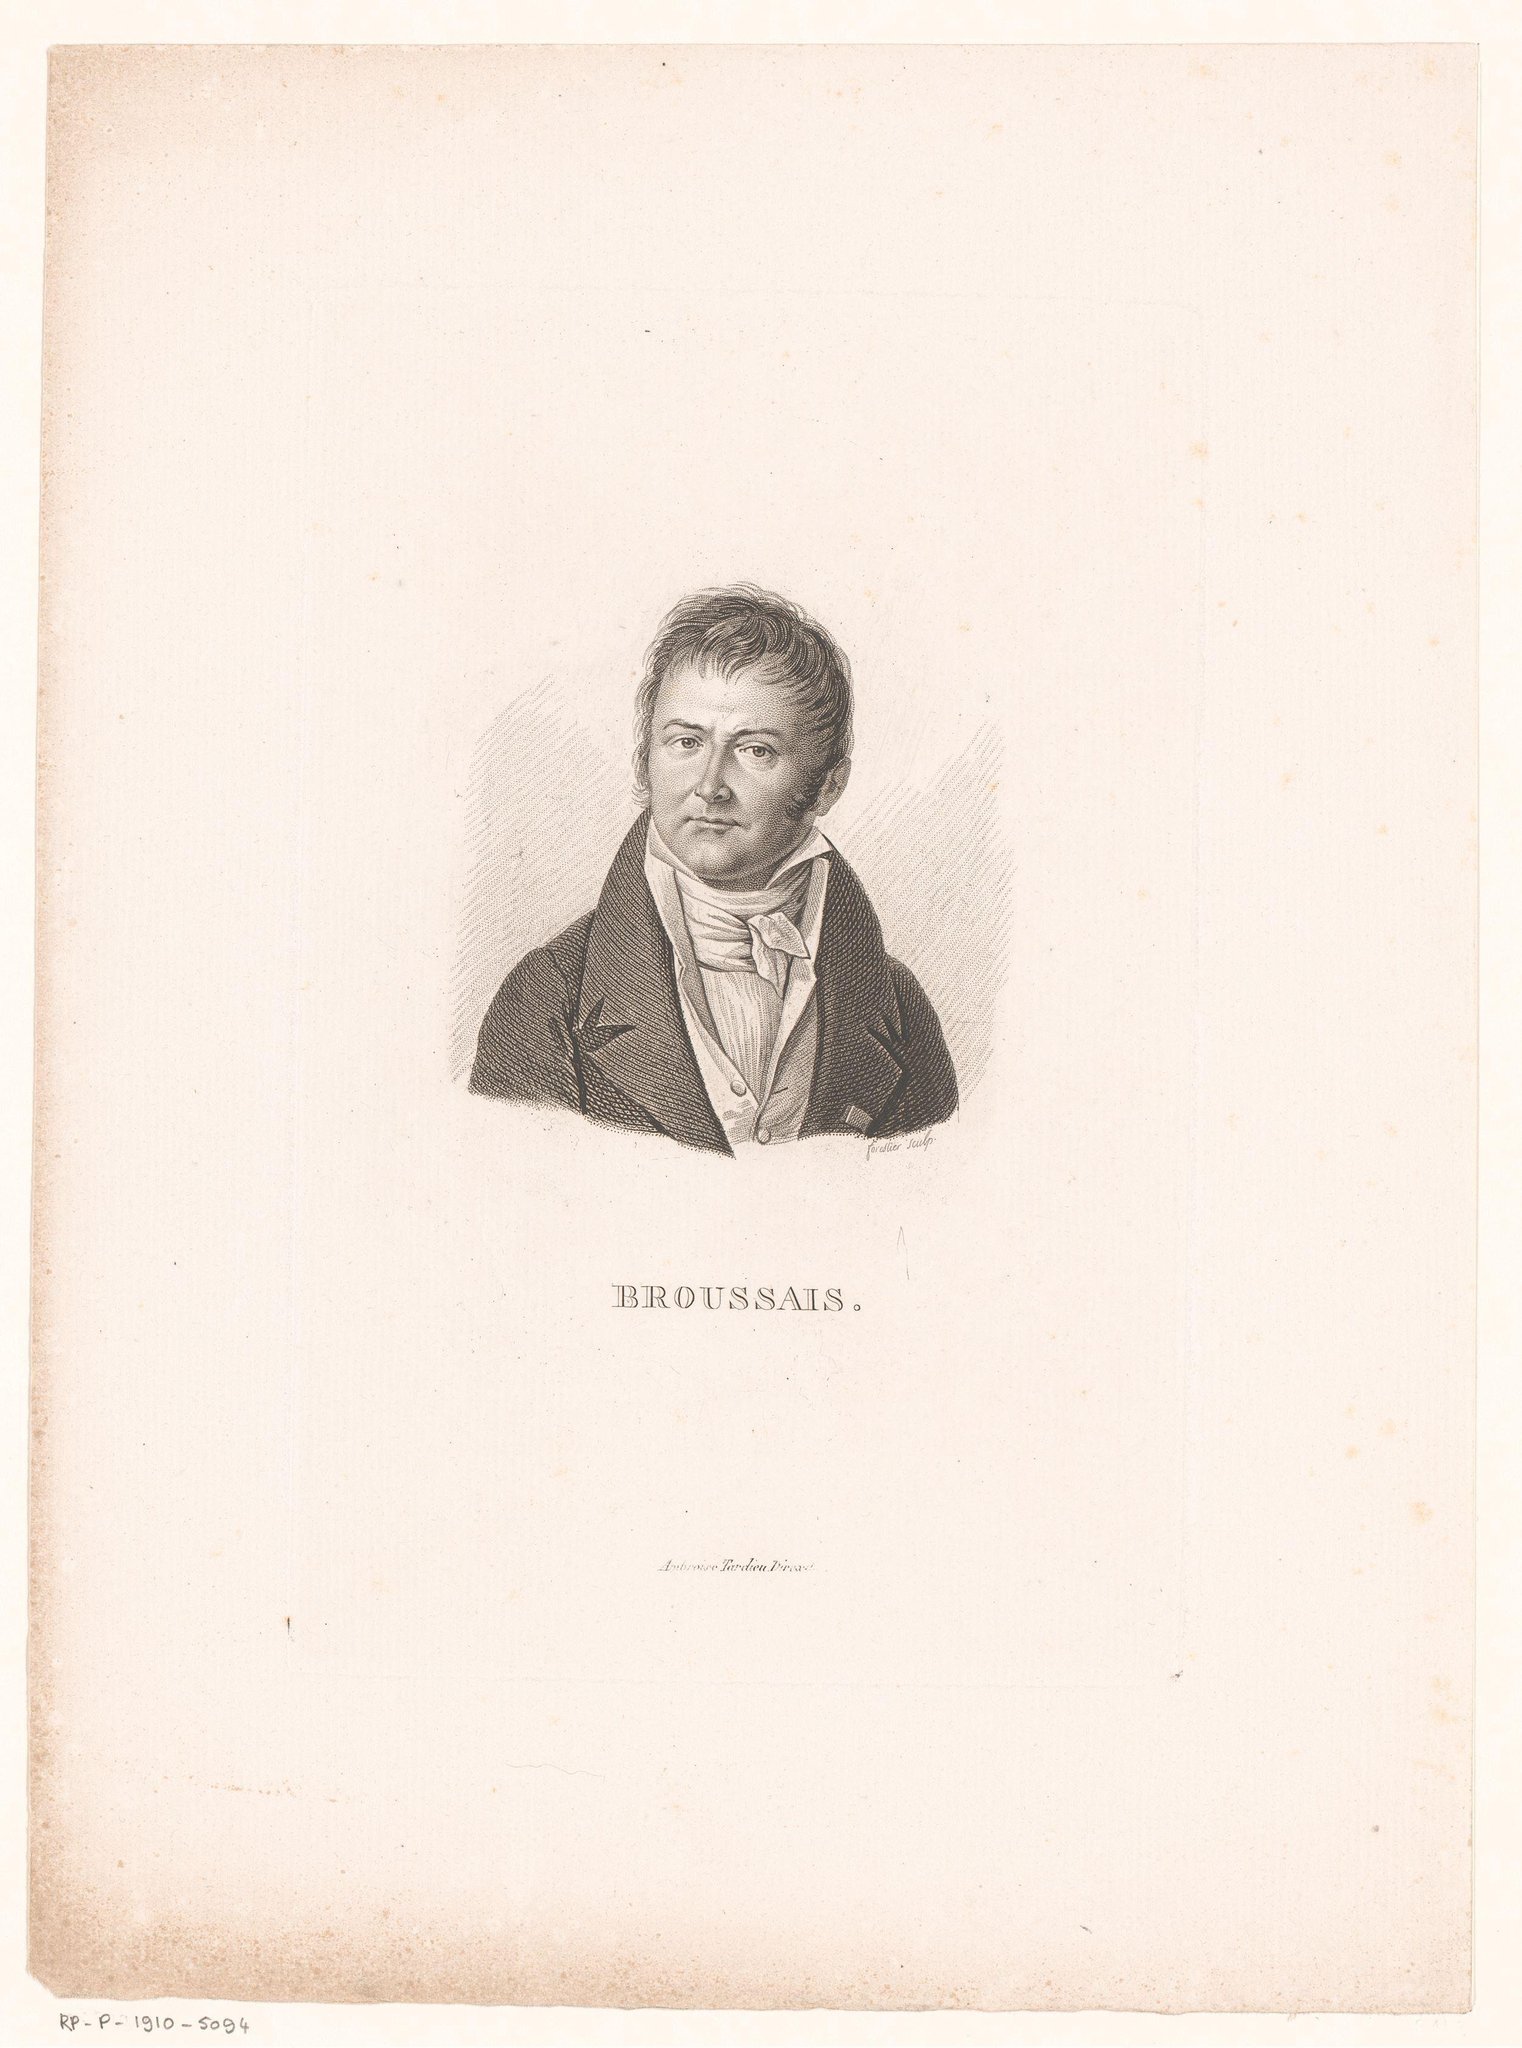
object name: print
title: Portret van François Broussais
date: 1818-1832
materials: paper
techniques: engraving, roulette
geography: france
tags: historical persons, physician, doctor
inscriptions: collector's mark: Lugt 2228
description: Mogelijk prent uit: Journal complémentaire du Dictionnaire des sciences médicales. Parijs: Panckoucke, Charles Louis Fleury, 1818-1832.